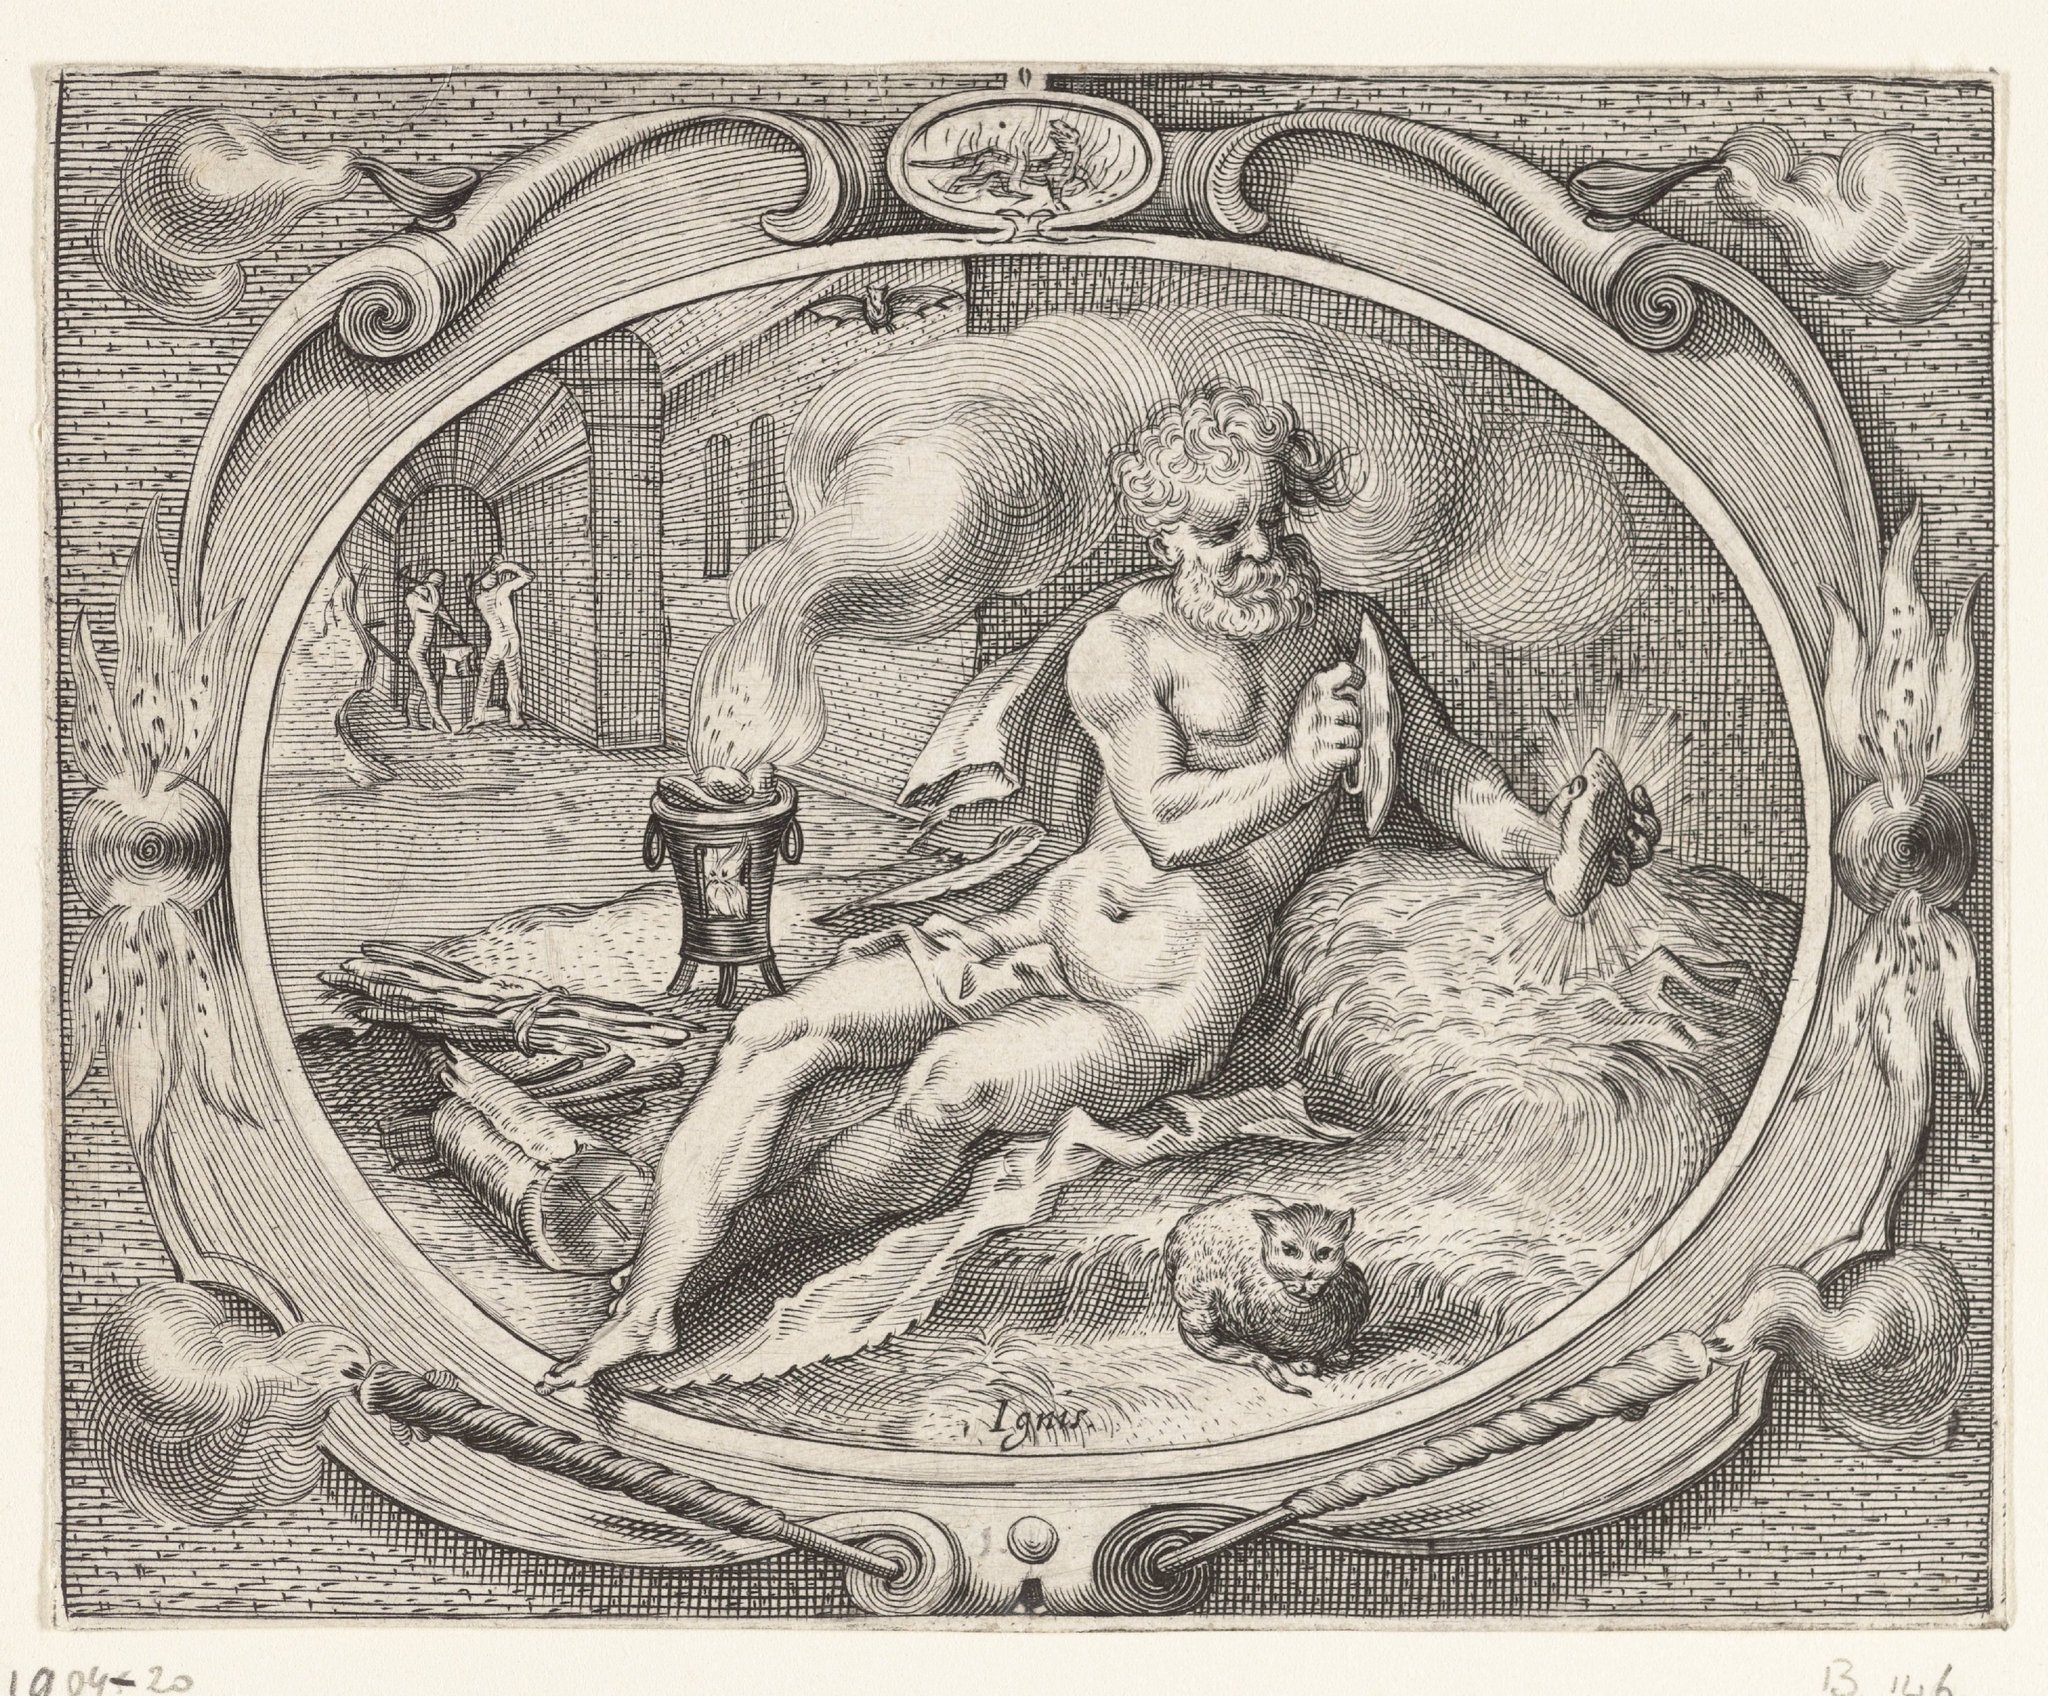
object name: print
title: Ignis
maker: jacob matham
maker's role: draughtsman, print maker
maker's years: 1571-1631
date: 1606-1610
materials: paper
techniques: engraving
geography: haarlem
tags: fire (one of the four elements)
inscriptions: collector's mark: Lugt 2228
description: De personificatie van het element vuur (ignis): een man slaat vuurstenen tegen elkaar naast een vuurkorf. Op de voorgrond een kat en op de achtergrond slaan twee figuren op een aambeeld in een smidse. Tweede prent uit een serie van de vier elementen.